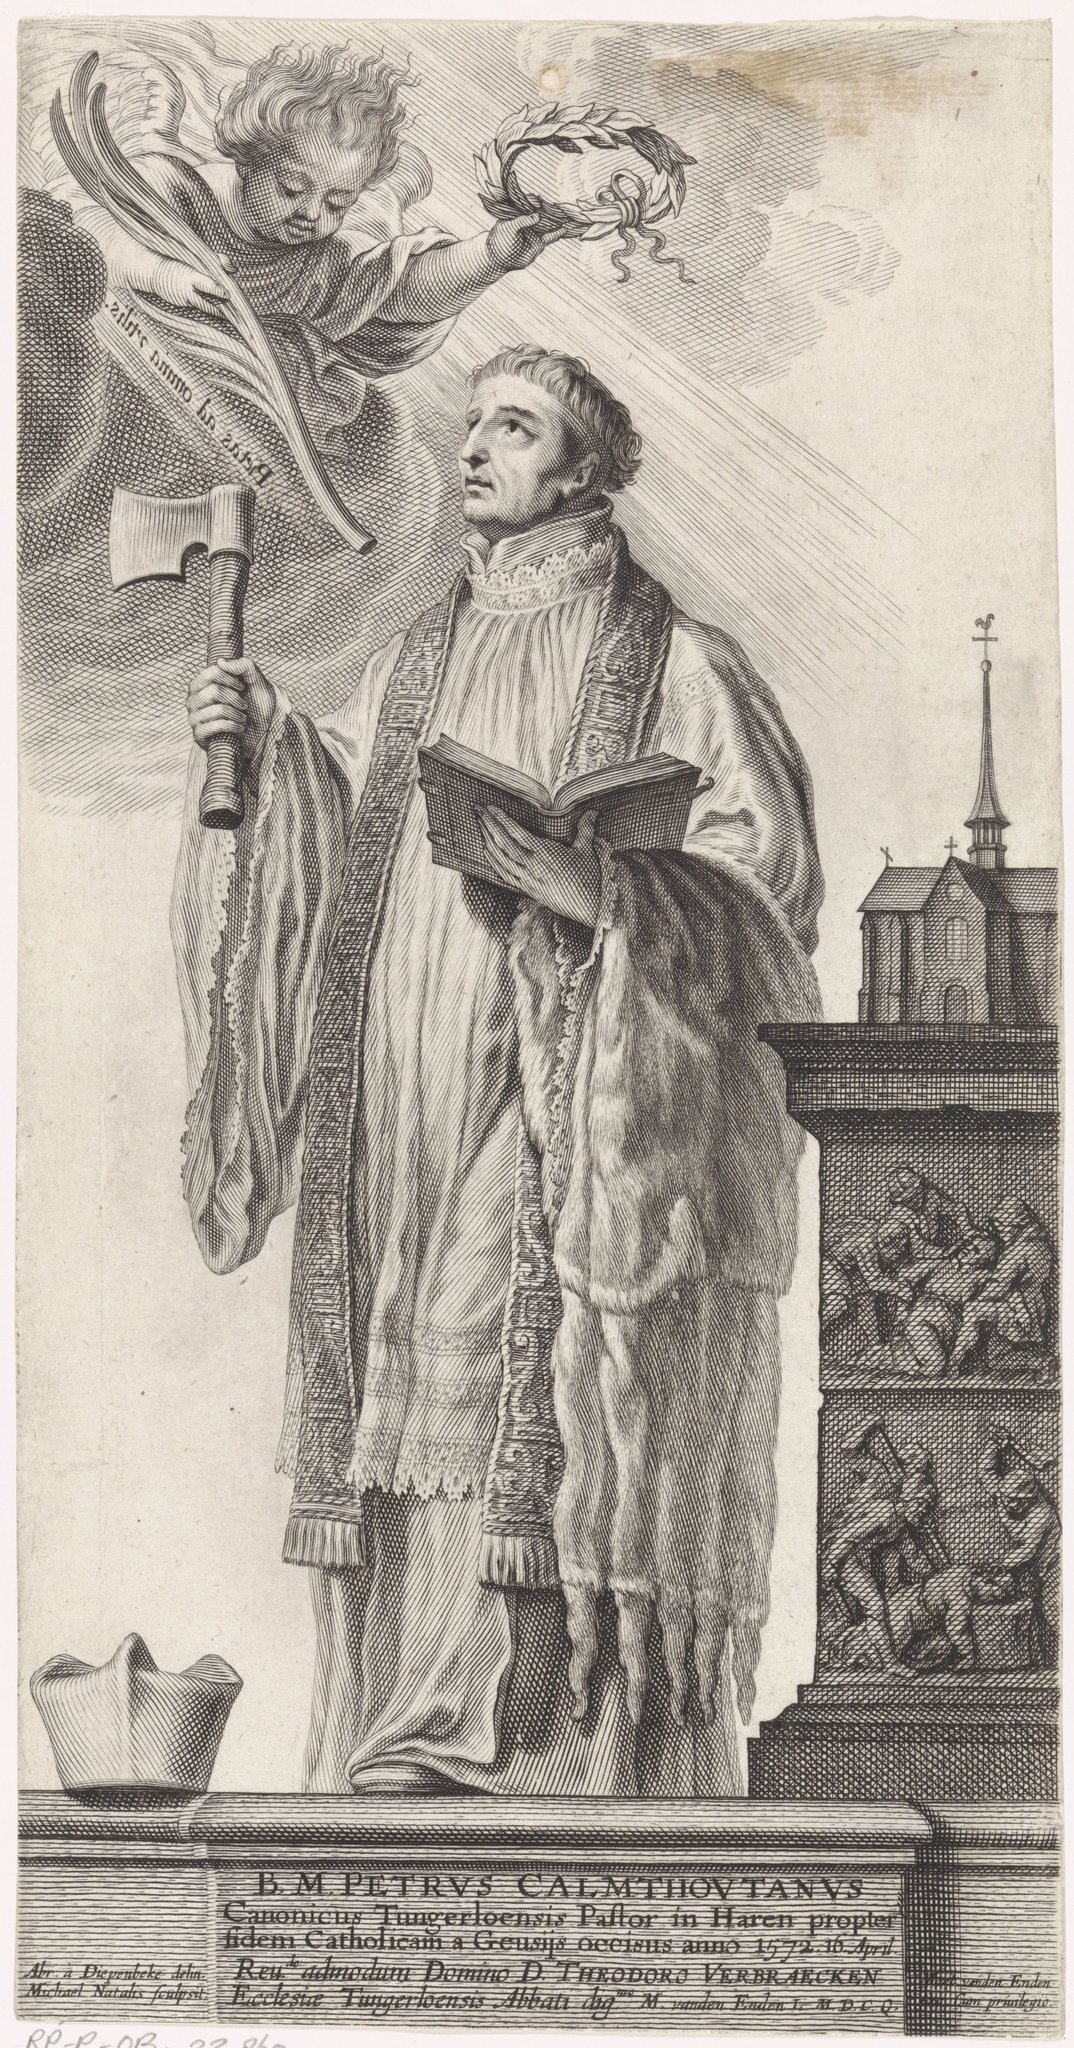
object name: print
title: B.M. Petrus Calmthoutanus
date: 1620-1668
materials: paper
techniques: engraving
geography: antwerp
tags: male saints (with name)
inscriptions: collector's mark: Lugt 2880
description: De heilige Petrus van Kalmpthout, gekleed in premonstratenzer kleding, een bijl in de ene hand, een Bijbel in de andere hand. Een engel op de wolken houdt een palmtak vast en kroont hem met een lauwerkrans. Naast Petrus van Kalmpthout staat het model van een kerk op een sokkel. Op de sokkel twee reliëfs, die zijn marteldood verbeelden. Onderaan op het pedestal een vierregelige tekst in het Latijn. Prent uit een serie van heiligen.